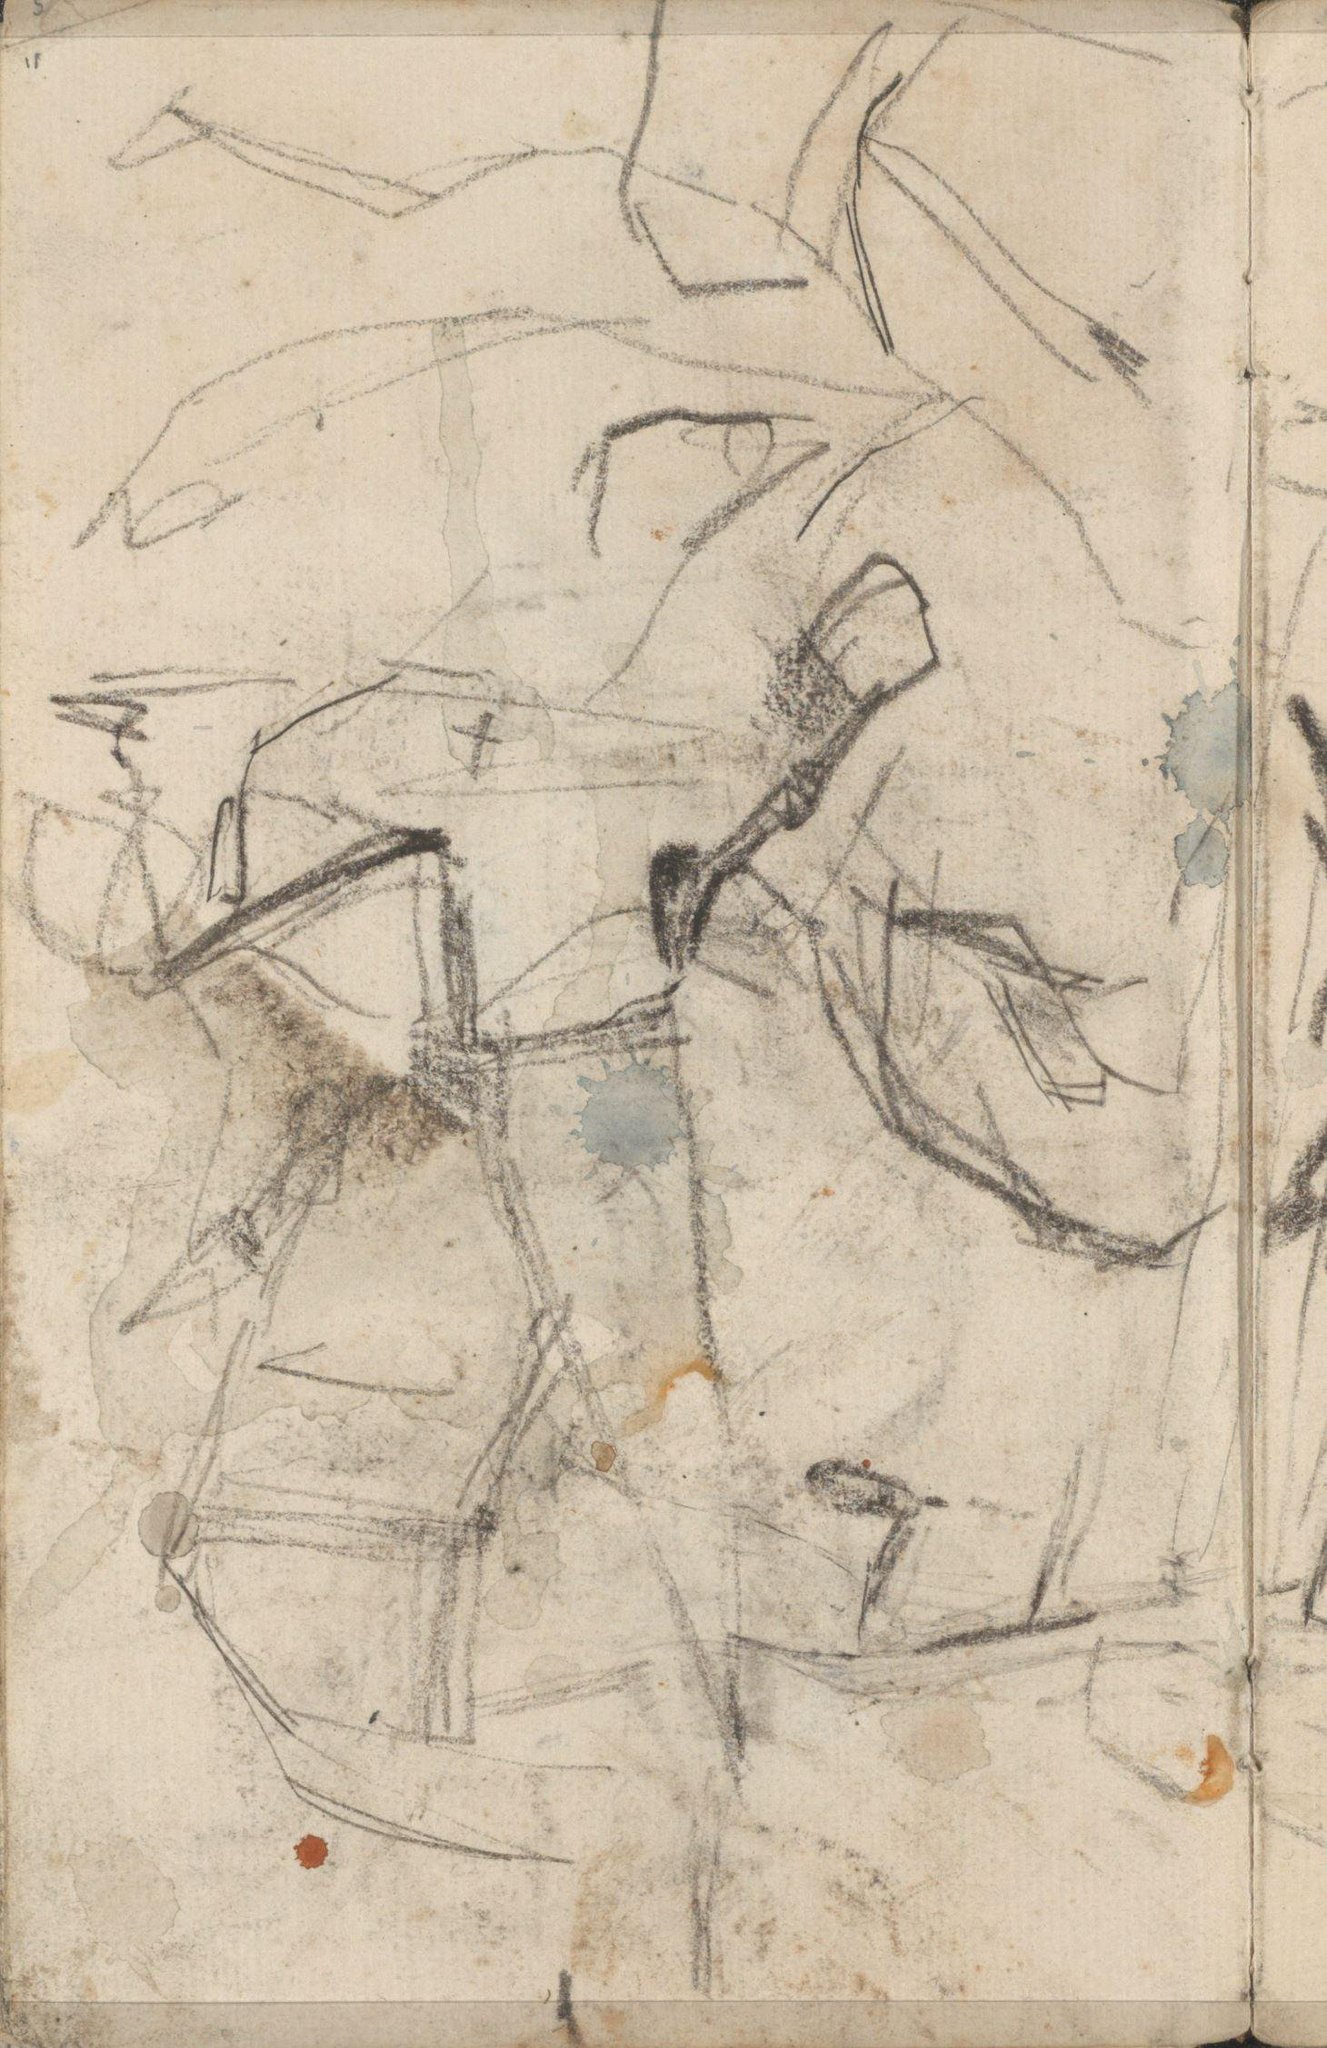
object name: sketchbook leaf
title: Studie, mogelijk van een ruiter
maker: george hendrik breitner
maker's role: draughtsman, painter, print maker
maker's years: 1857-1923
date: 1884-1886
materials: chalk, paper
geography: the hague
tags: riding a horse, ass, or mule; rider, horseman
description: Pagina 11 uit een schetsboek met 29 bladen.